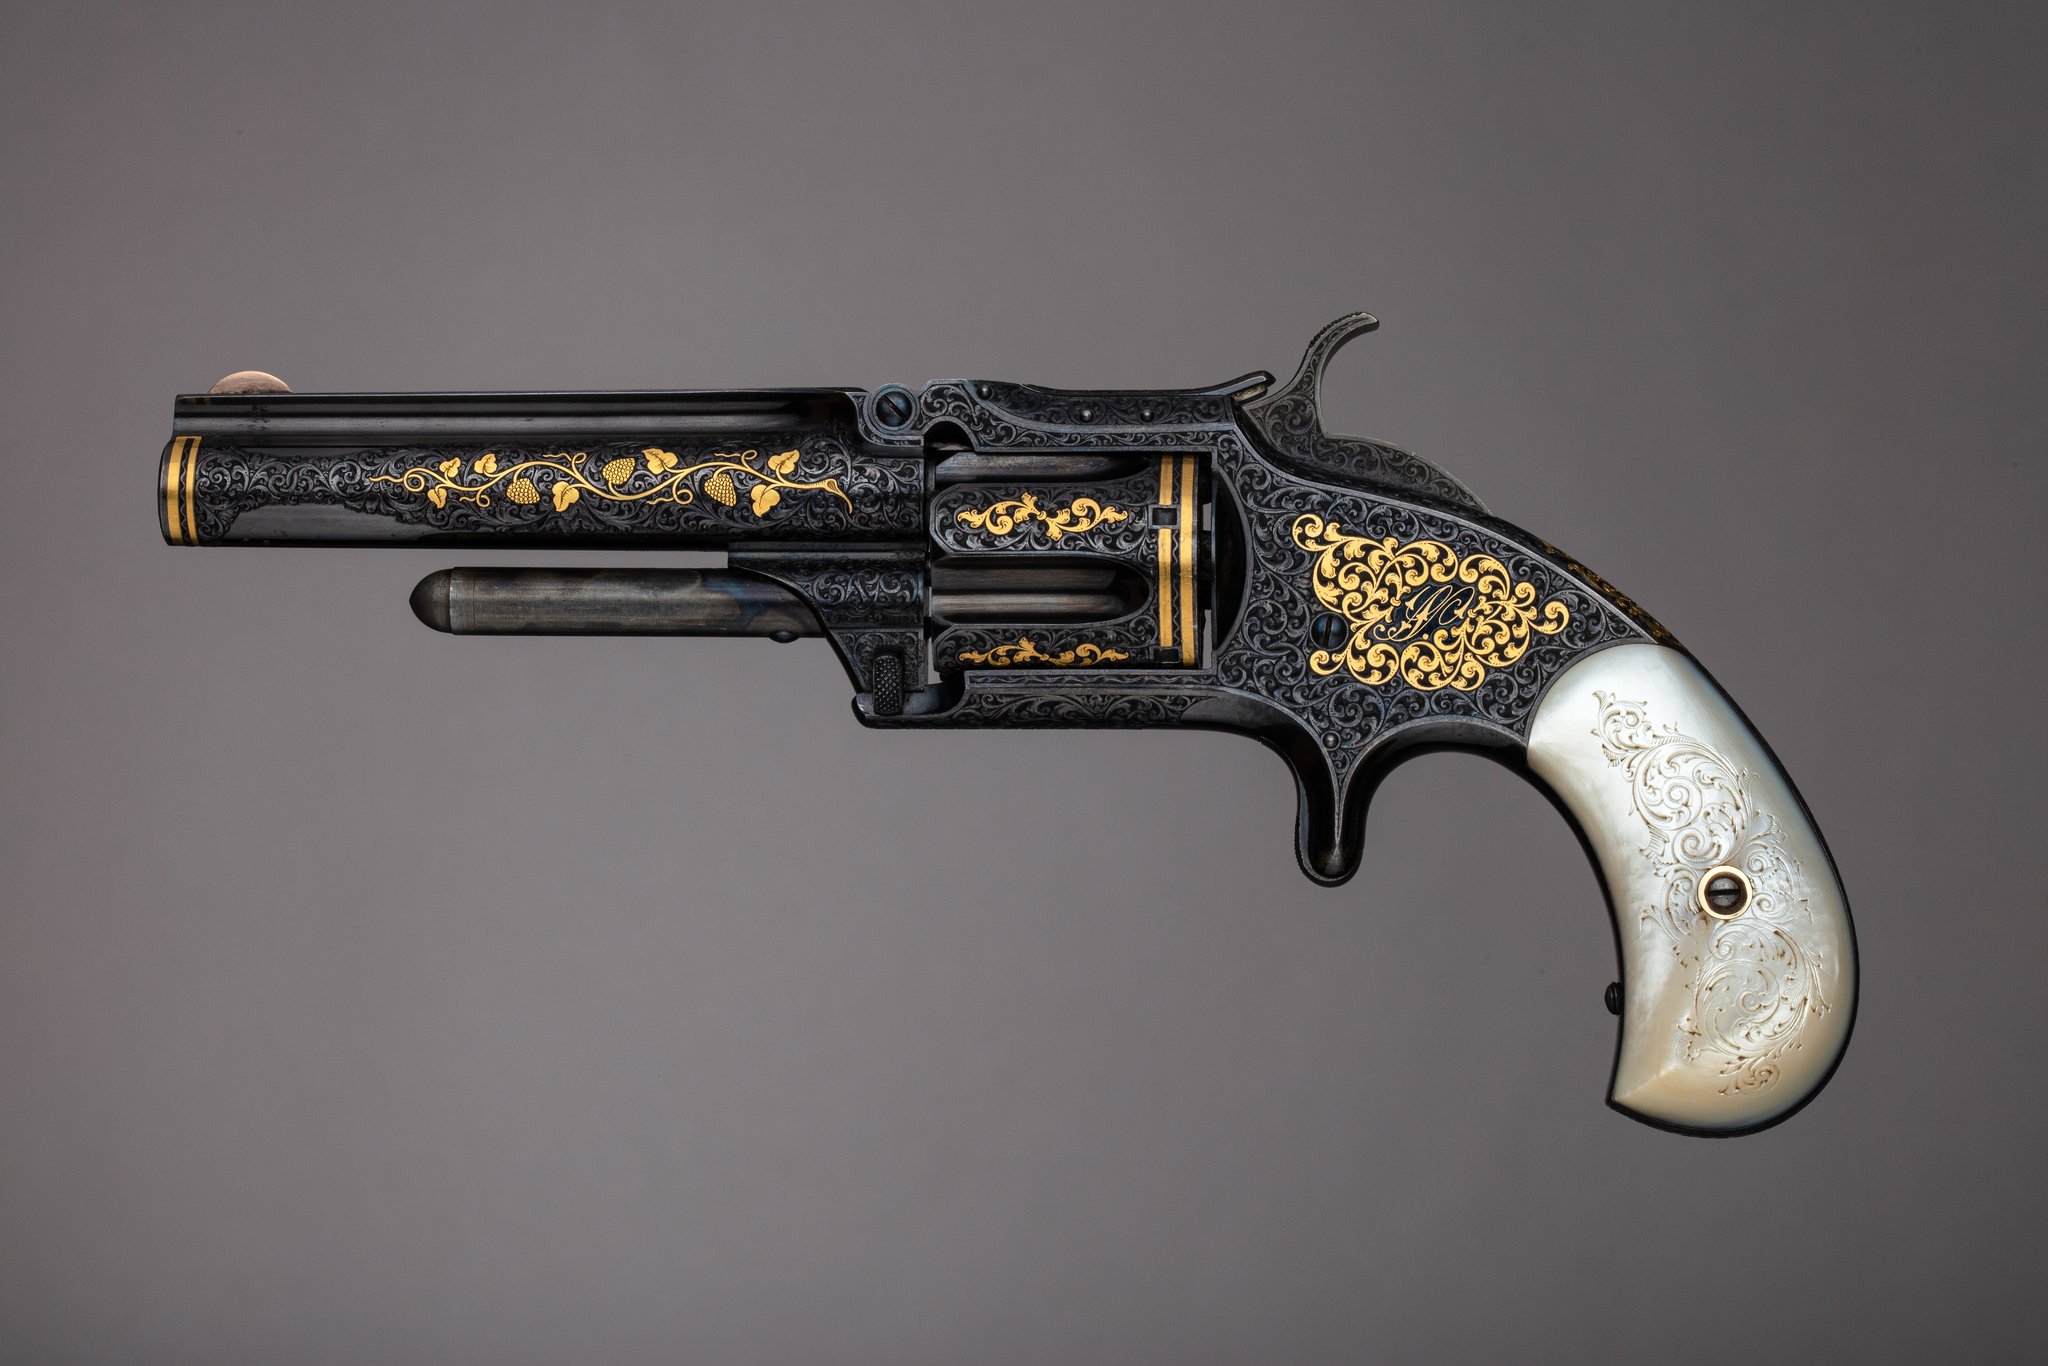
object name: revolver with case and accessory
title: Smith & Wesson Model 1 ½ Second Issue Revolver (serial no. 30451) with Case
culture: american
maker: smith & wesson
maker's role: manufacturer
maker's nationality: american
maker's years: 1852-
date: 1869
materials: brass, gold, mother of pearl, silver, steel, velvet, wood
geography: united states